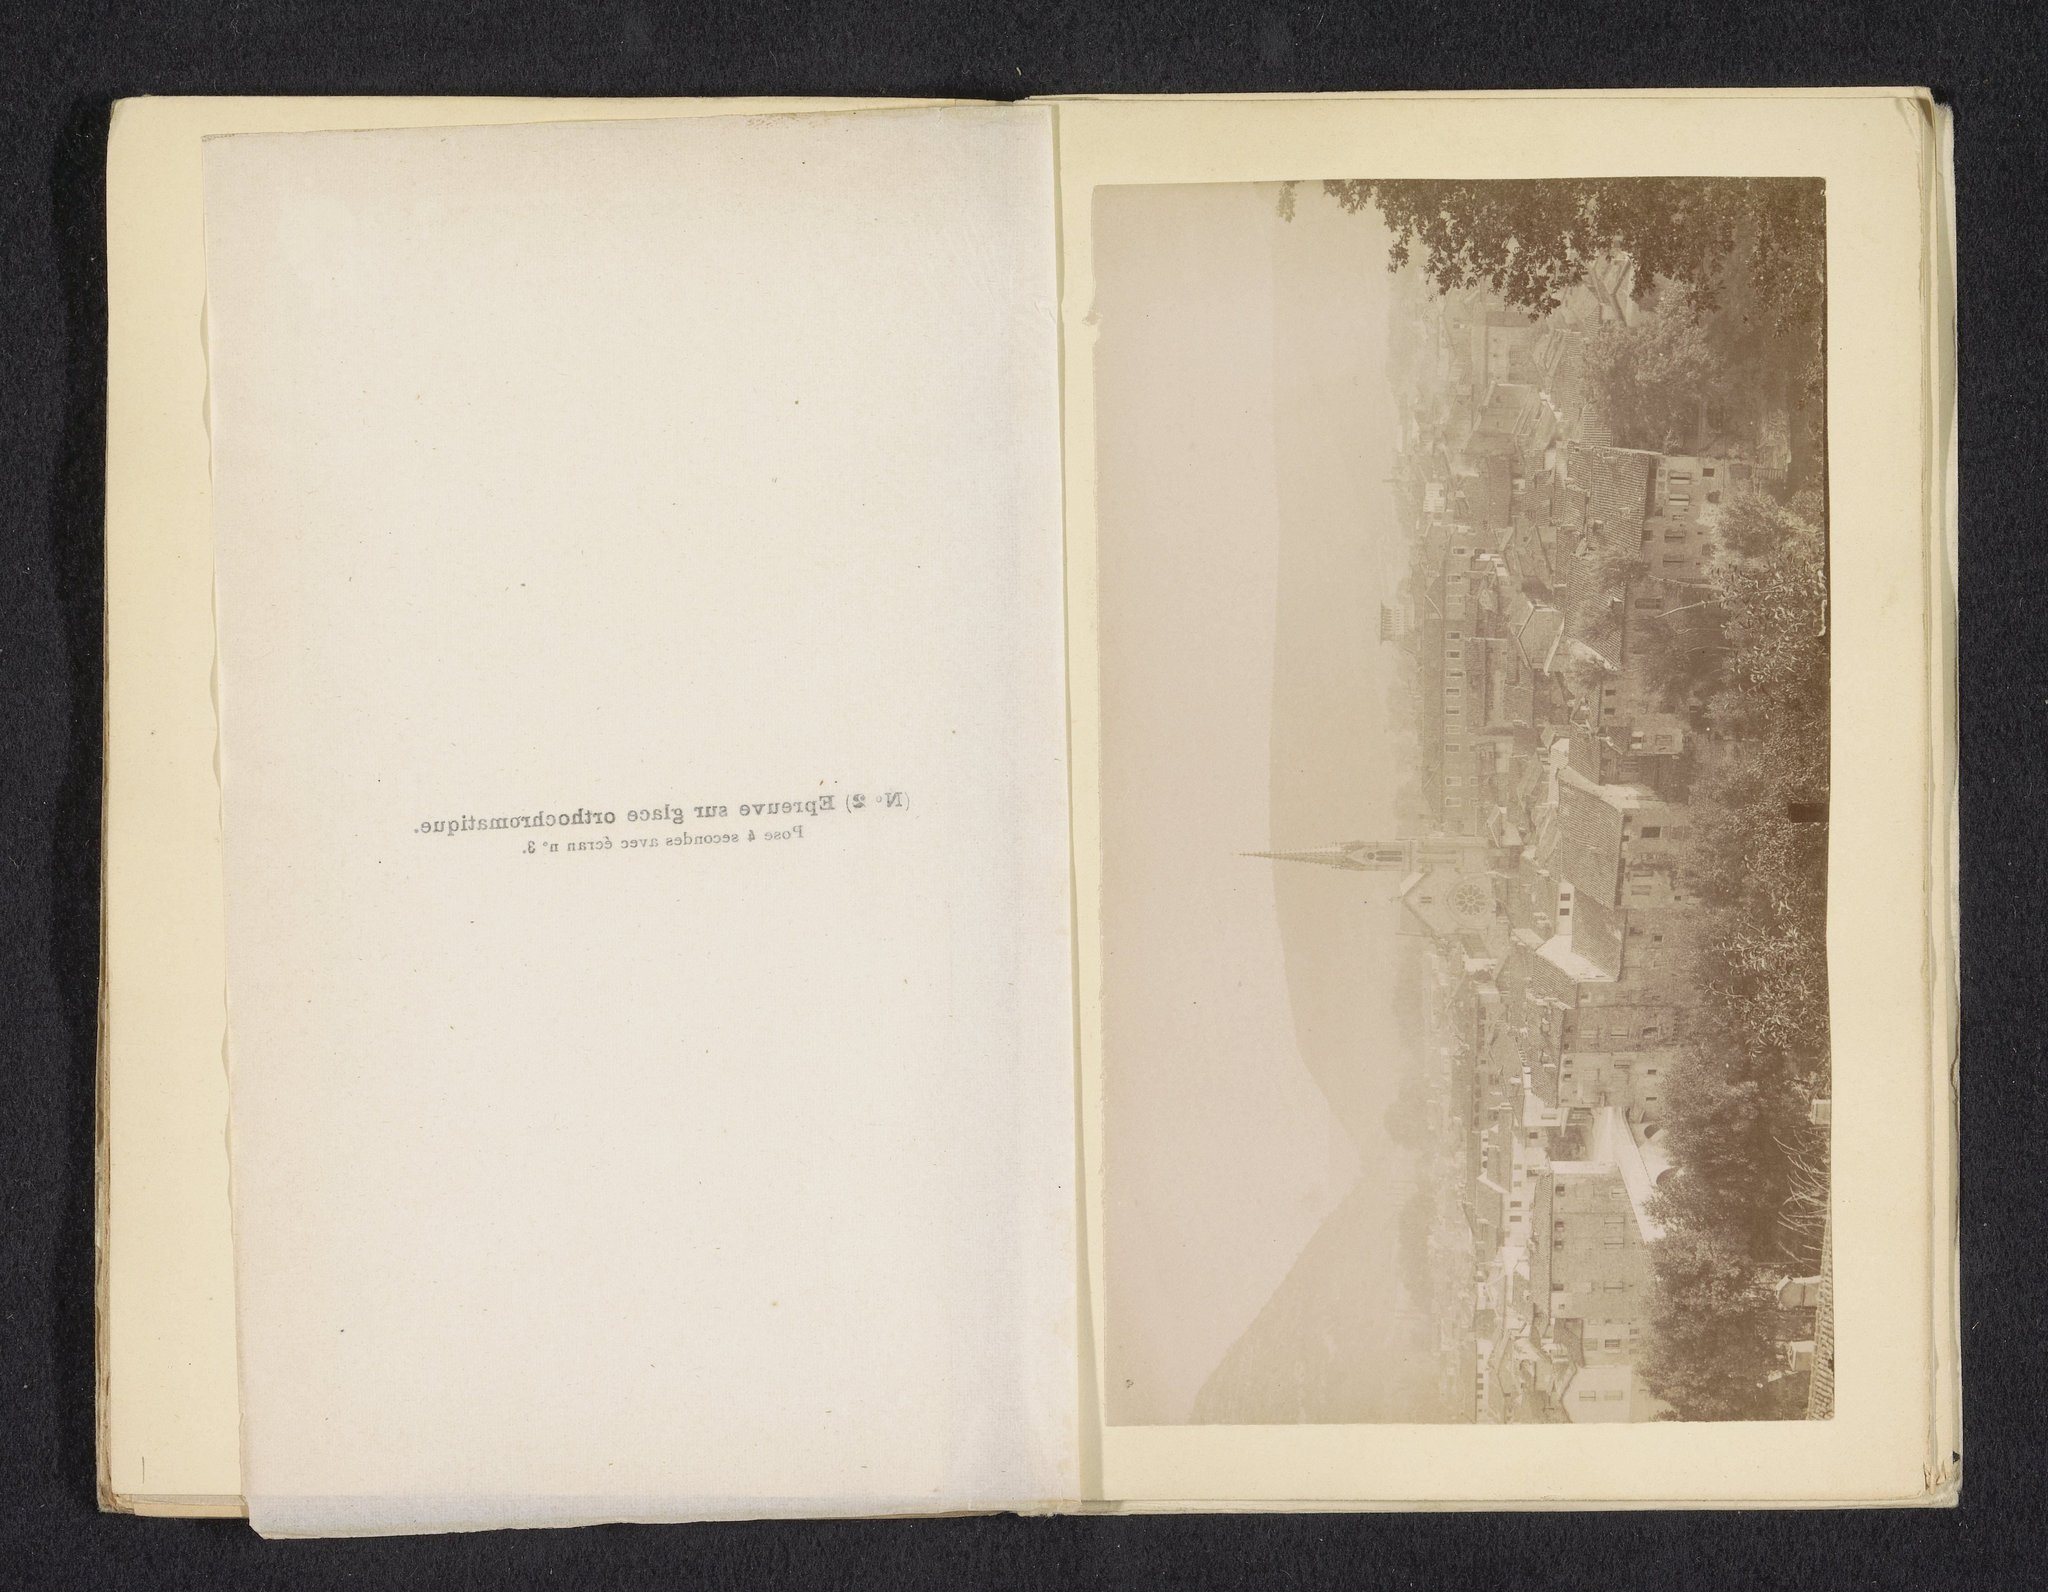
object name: page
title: Gezicht op een stad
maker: Anonymous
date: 1882-1892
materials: photographic support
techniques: albumen print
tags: city-view in general; 'veduta'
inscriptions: inscription: ‘Epreuve sur glace orthochromatique. Pose 4 secondes avec écran no 3.’, number: ‘(No 2)’